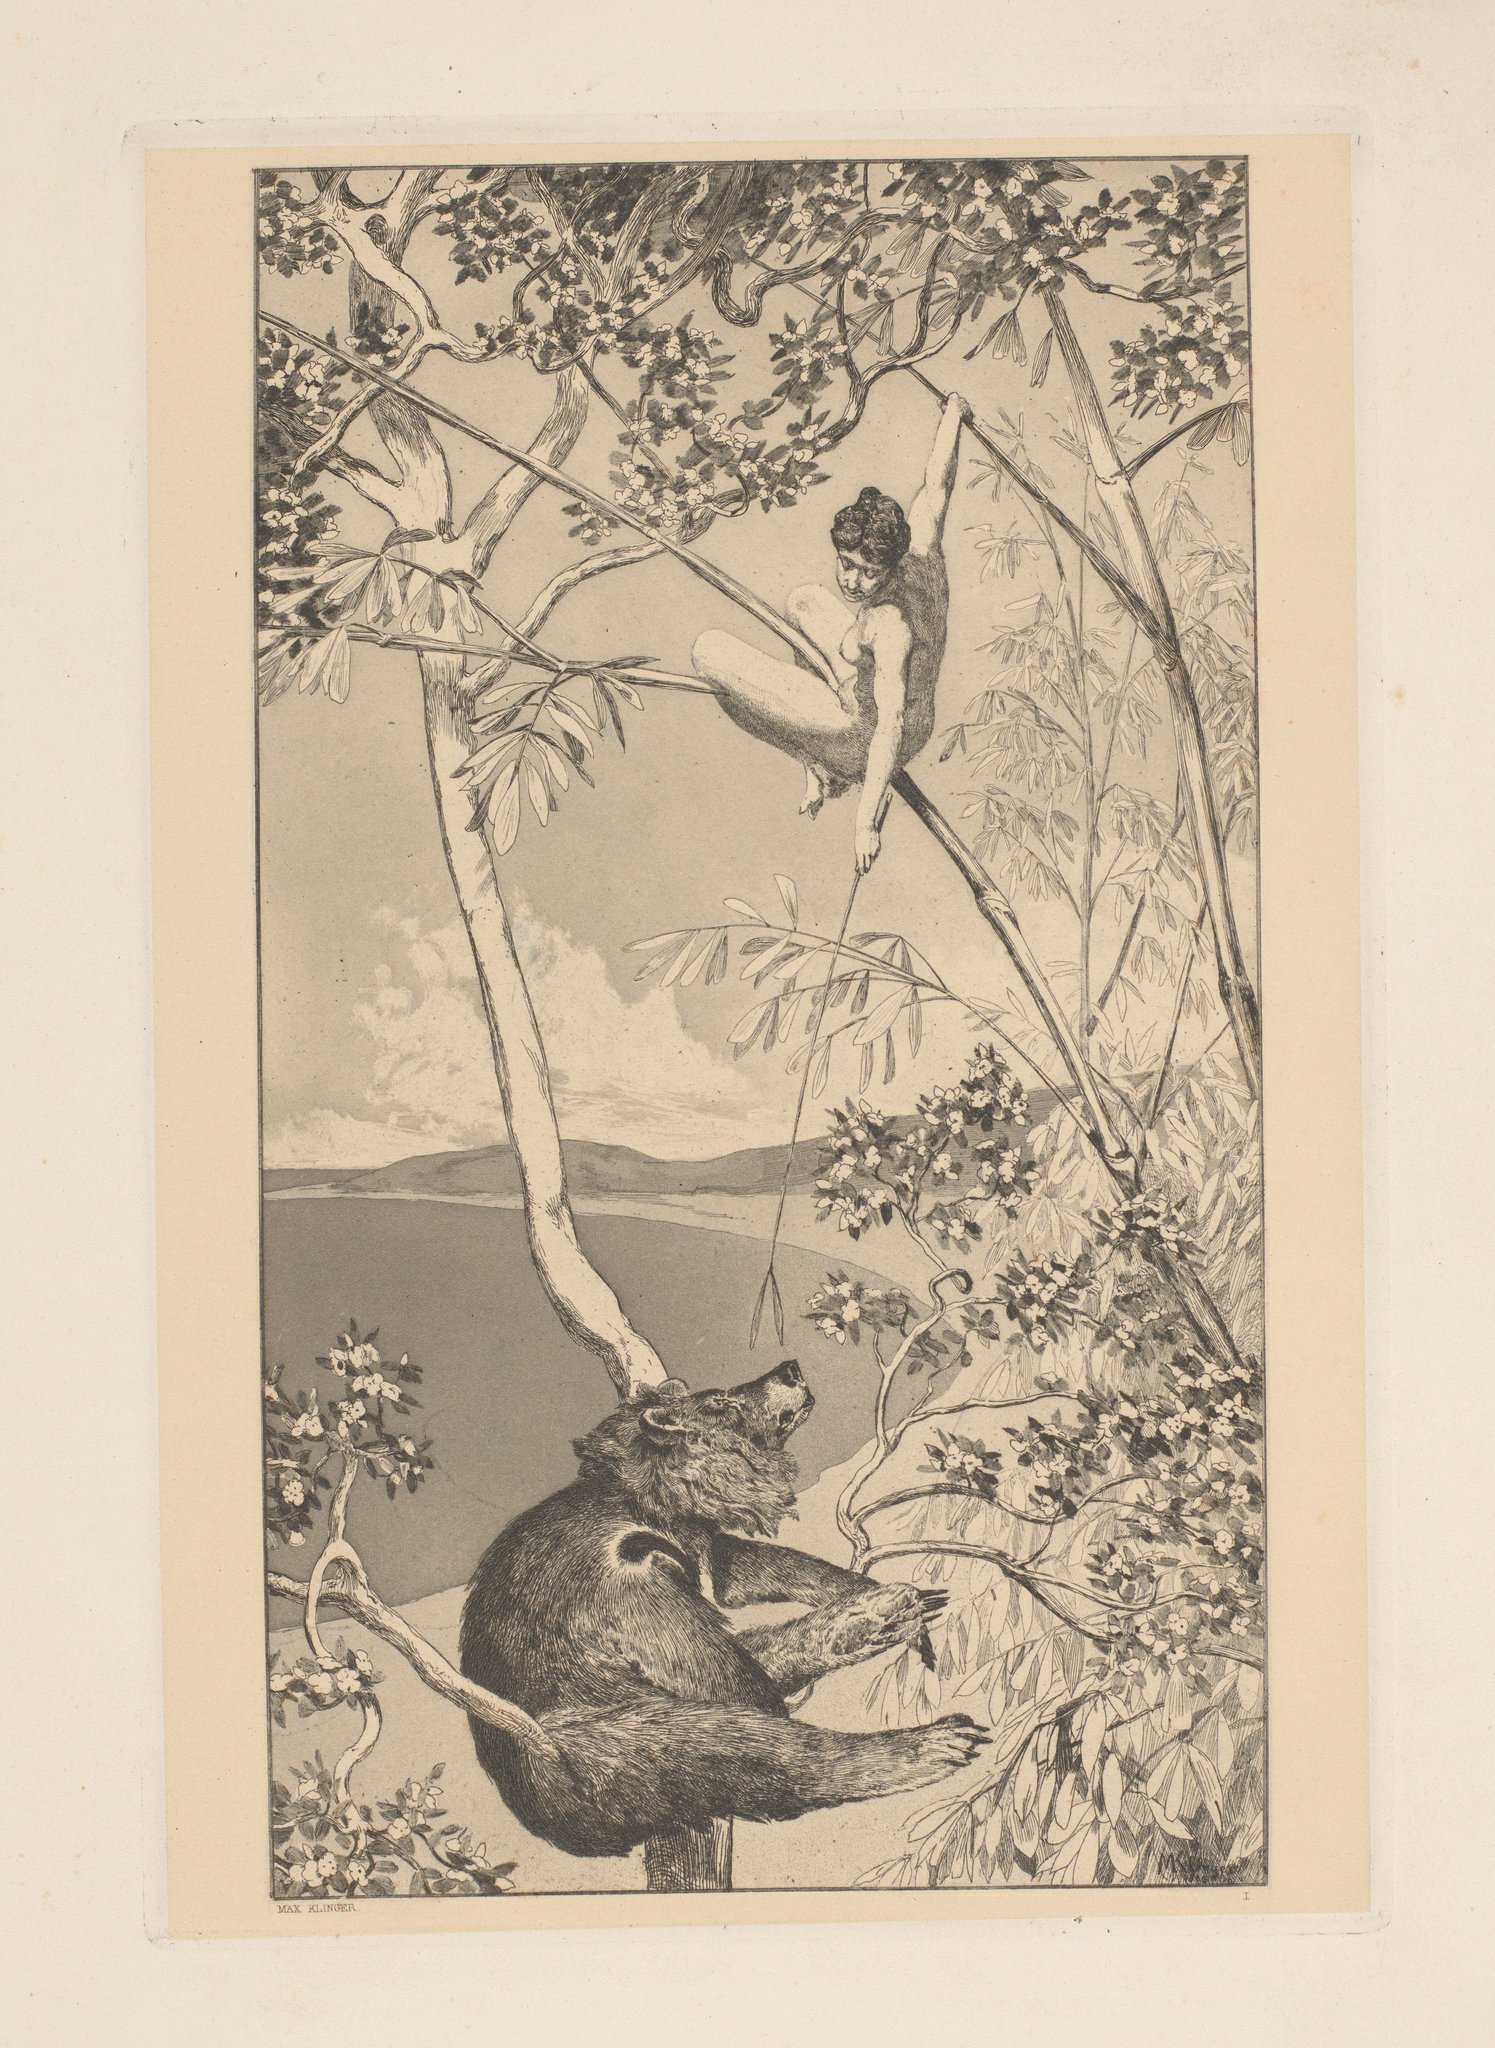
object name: print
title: Bär und Elfe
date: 1880-1881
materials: paper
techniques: aquatint, etching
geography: nuremberg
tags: elf - aa - female human figur, beasts of prey, predatory animals: bear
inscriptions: collector's mark: Lugt 2228